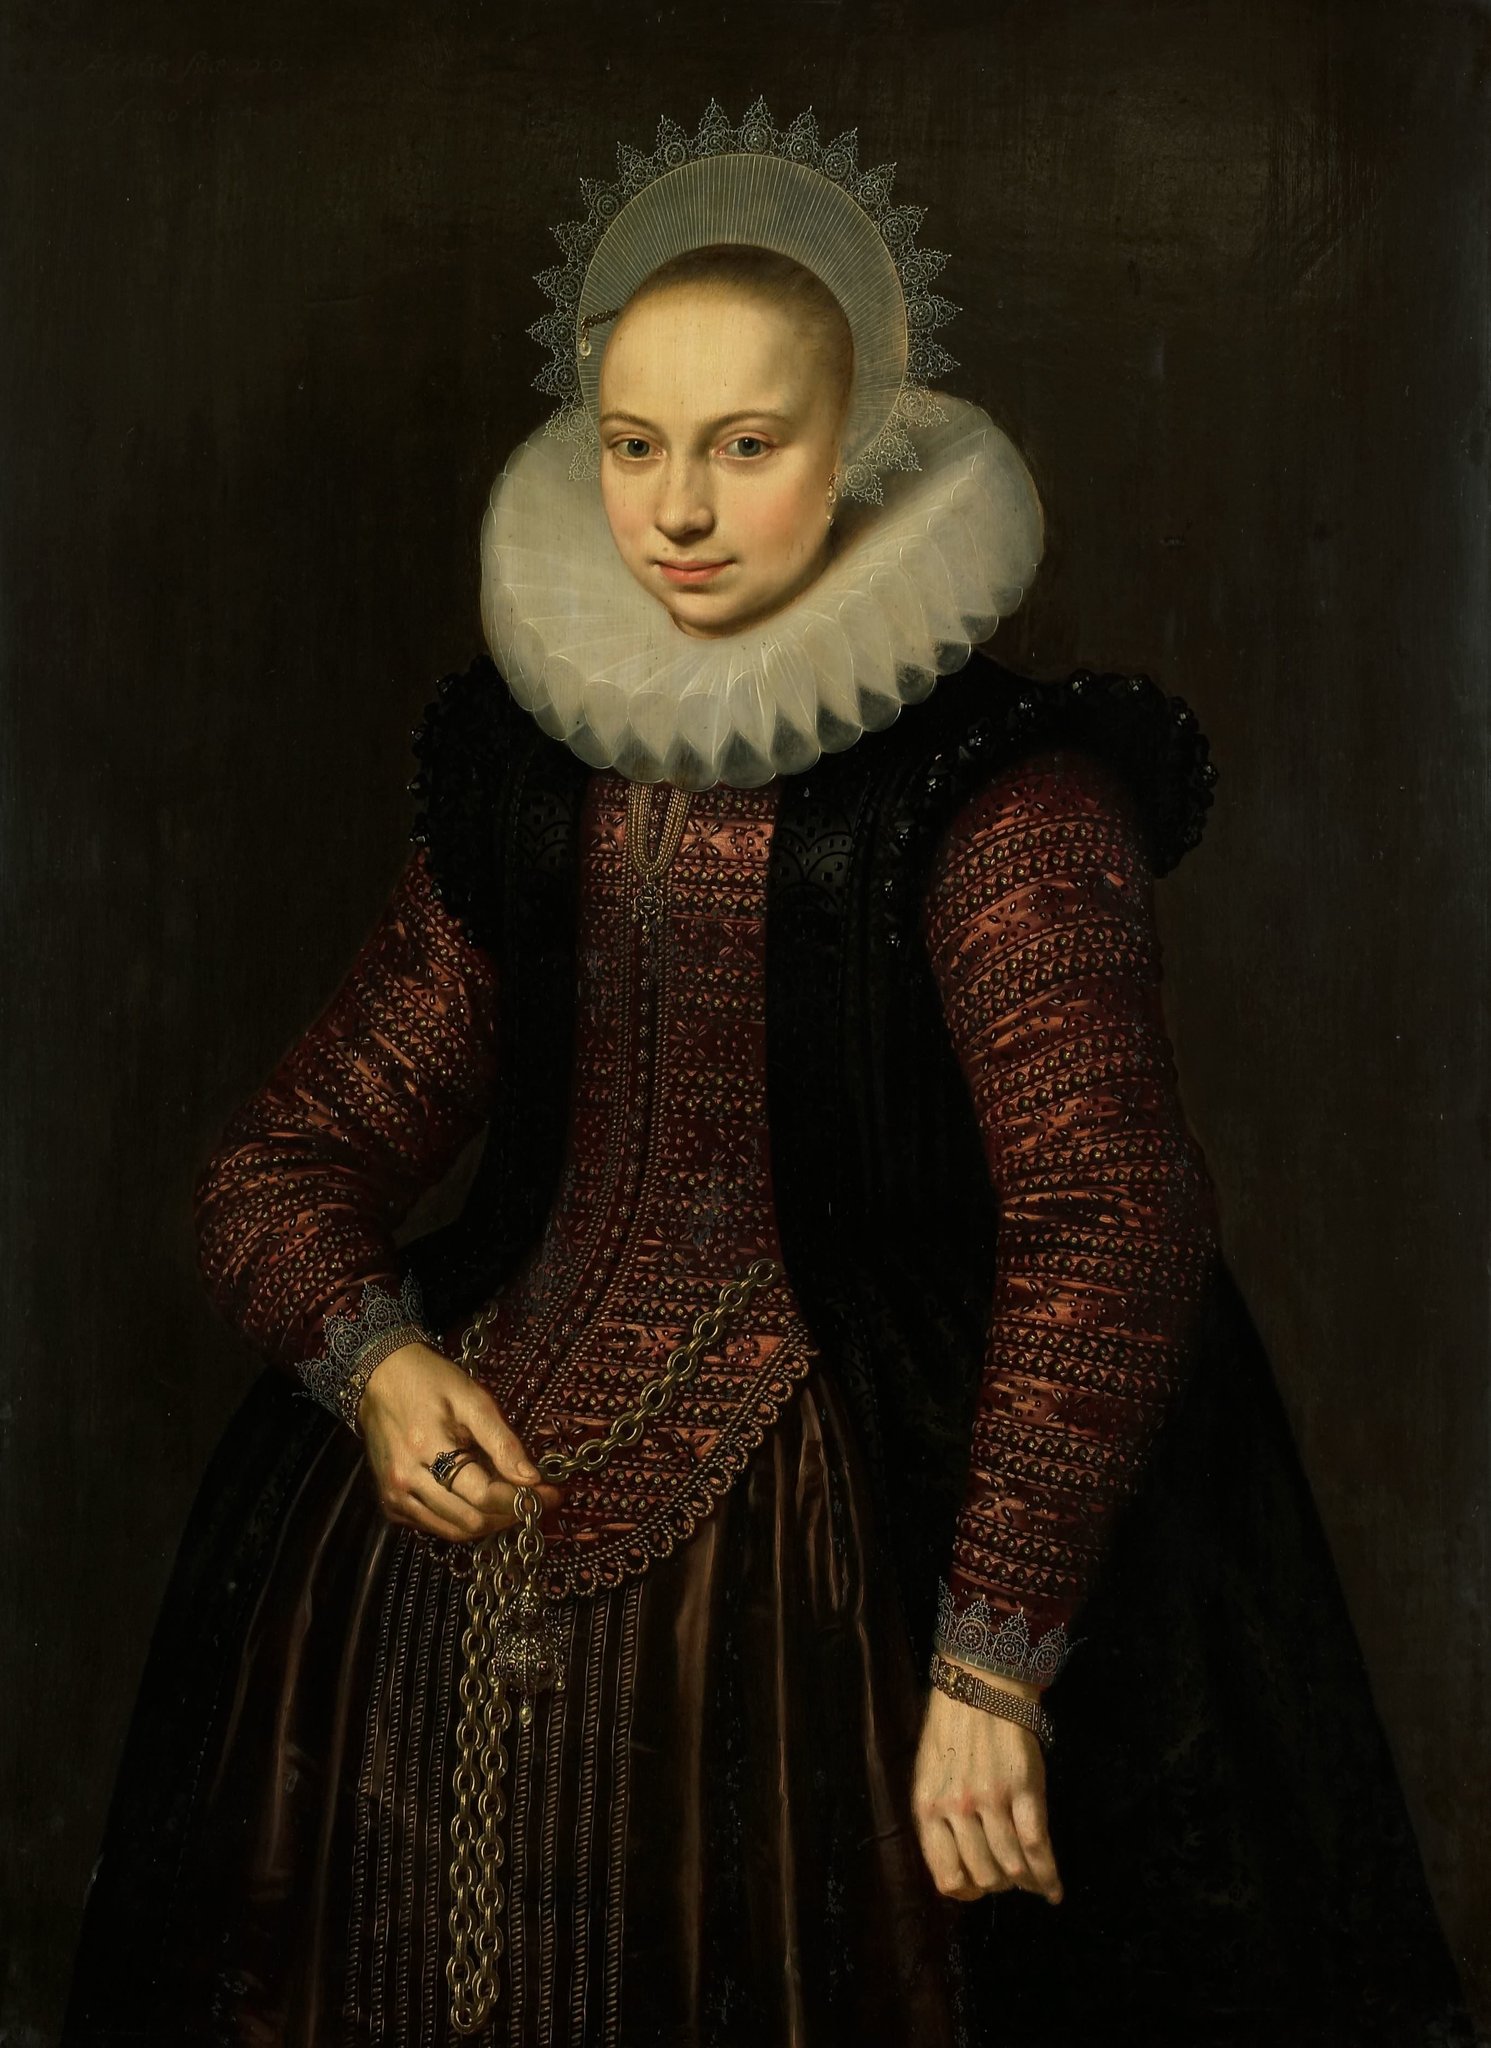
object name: painting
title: Portrait of Brechtje Overrijn van Schoterbosch (1592-1618)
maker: cornelis van der voort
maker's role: draughtsman, painter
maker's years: 1576-1624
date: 1614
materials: oil, panel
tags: haarlem, historical persons - bb - woman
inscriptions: label, on the reverse: ‘Dirk Hasselaar: Major van de Militie / Vader van / Aagje Hasselaar: vrouwe van / Henrich Hooft: Vader en Moeder van / Bregje Hooft: vrouwe van Harman van de Poll.’, inscription and date, upper left: ‘Ætatis Suae.22. / Anno 1614.’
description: Portret van Brechtje van Schoterbosch (1592-1618). Echtgenote van Dirck Hasselaer. Kniestuk, staande, ketting met hanger in de rechterhand. Pendant van SK-A-1242.